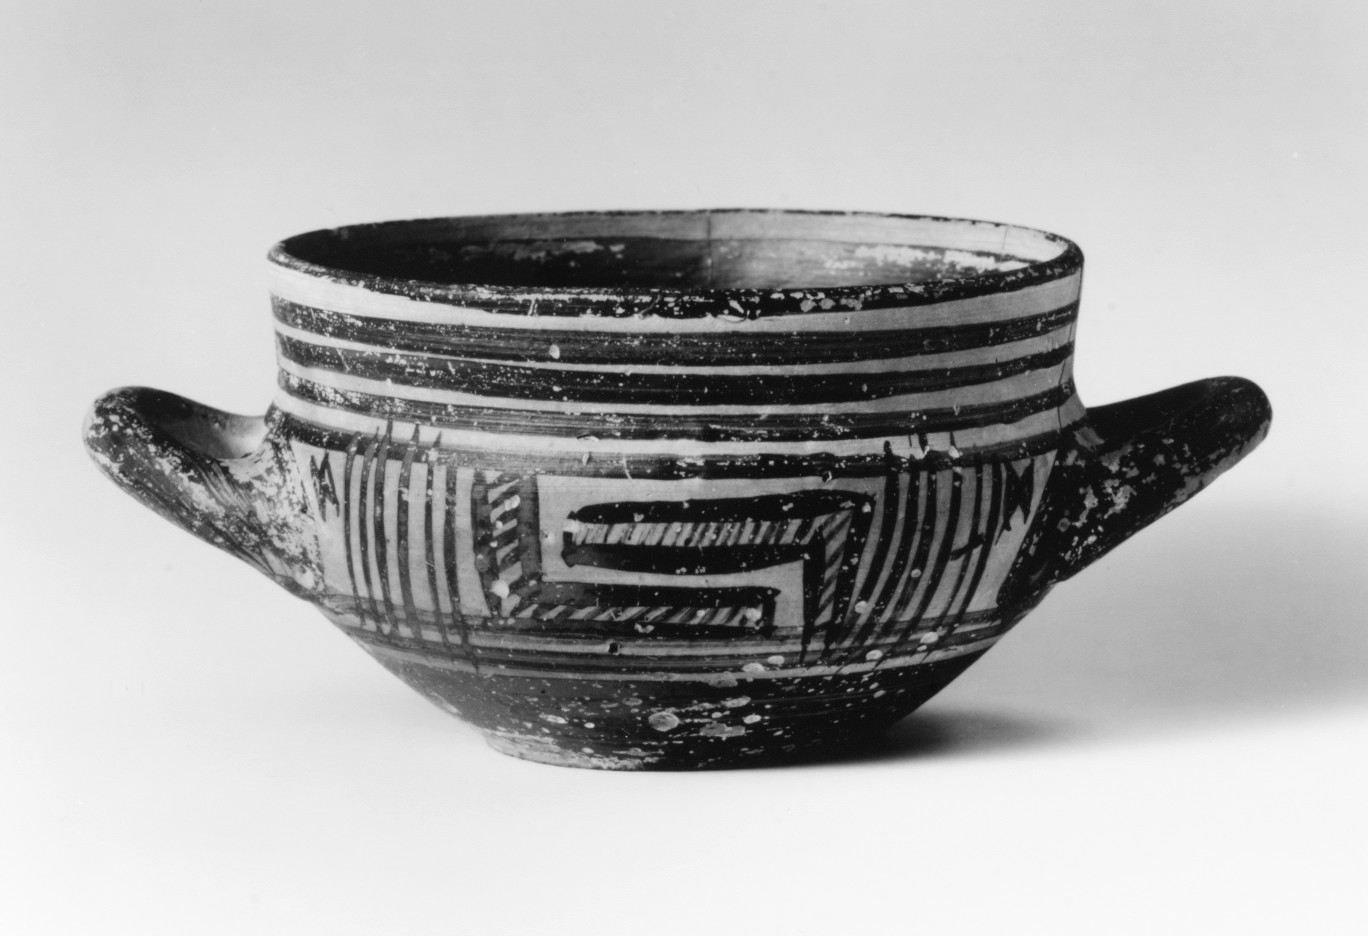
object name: bowl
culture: greek, attic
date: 800-701 BCE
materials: terracotta